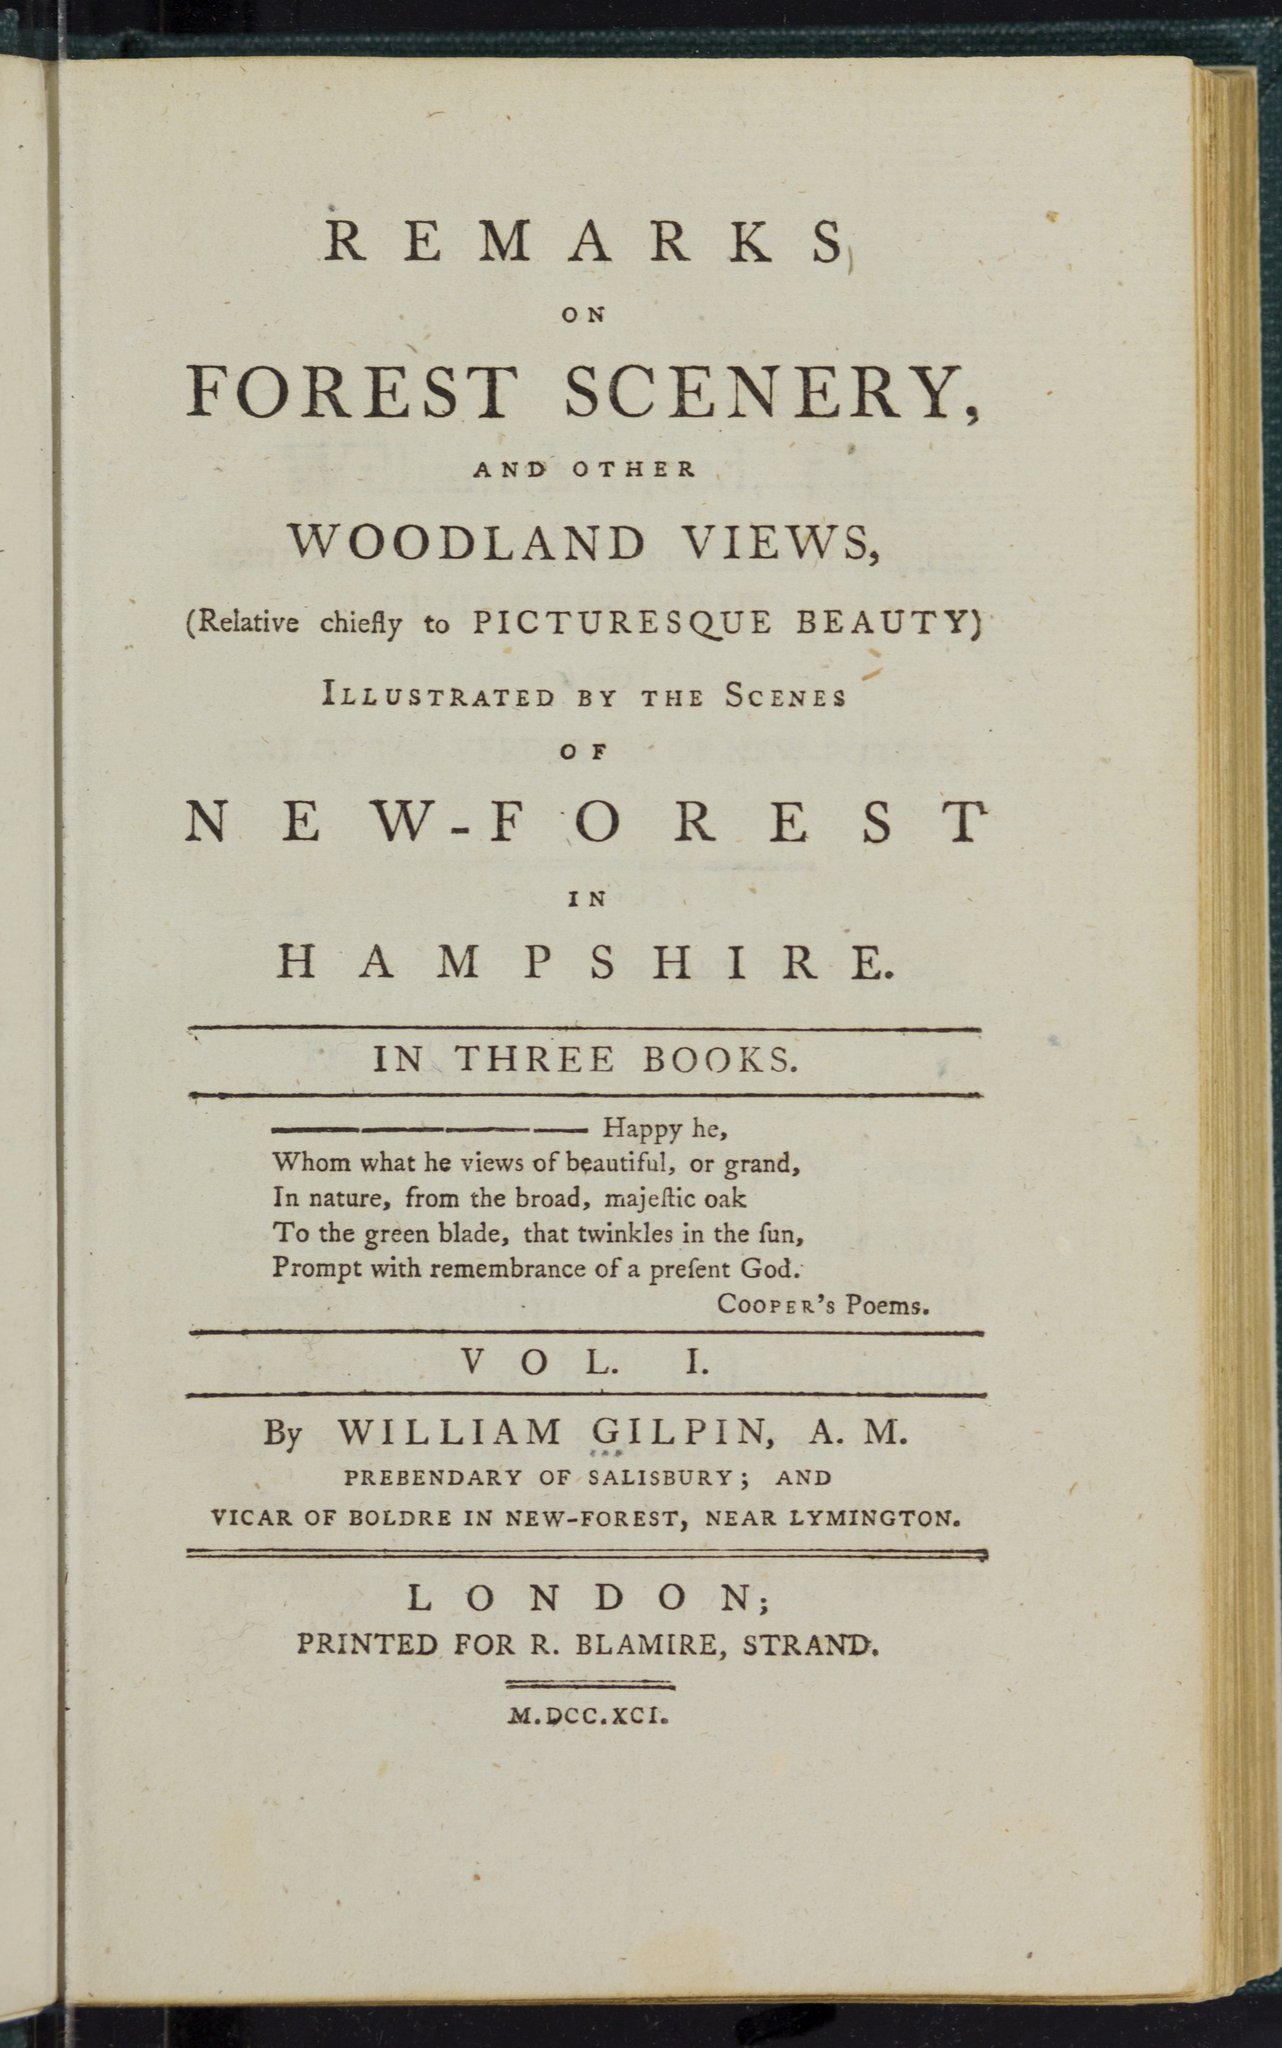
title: Remarks on forest scenery, and other woodland views, (relative chiefly to picturesque beauty) : Illustrated by the scenes of New-Forest in Hampshire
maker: william gilpin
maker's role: author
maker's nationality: british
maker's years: 1724-1804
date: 1791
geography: england